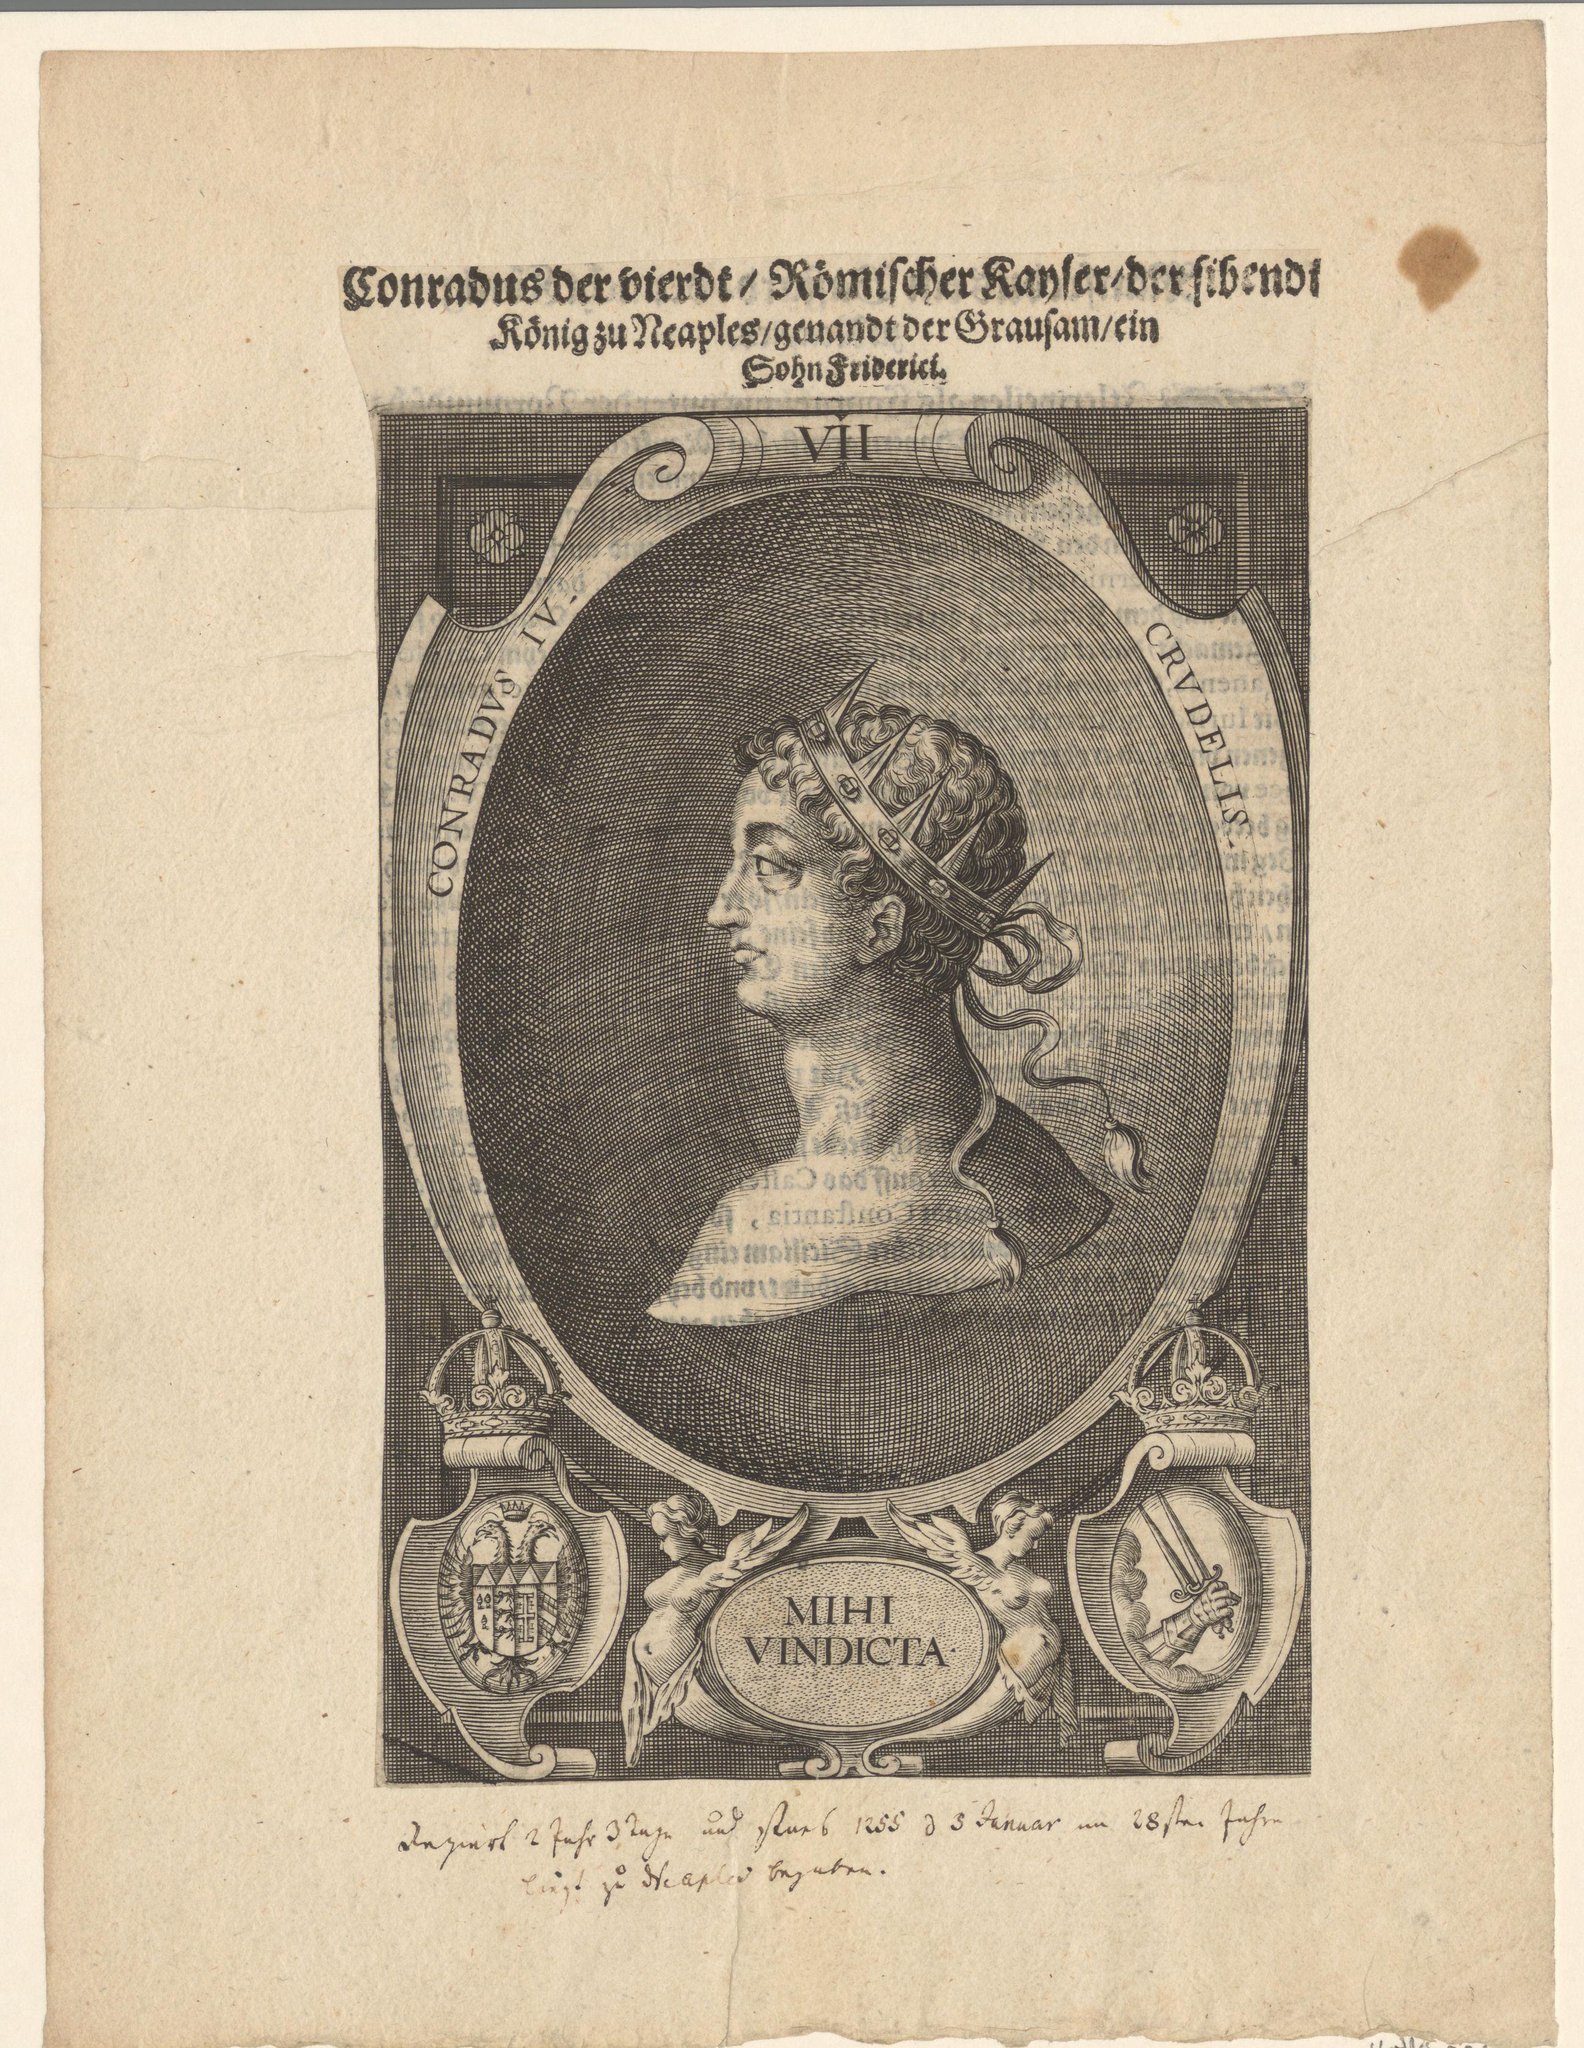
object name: print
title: Portret van koning Koenraad IV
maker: lucas kilian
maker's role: draughtsman, print maker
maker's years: 1579-1637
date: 1589-1624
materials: paper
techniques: engraving, etching, letterpress printing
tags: historical persons, king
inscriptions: collector's mark: Lugt 2228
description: Deze prent is gebruikt in: Mazzella, Scipione, Kilian, Lucas en Custos, Dominicus. Der Neapolitanische Koenige Leben und Bildnisse (...). Augsburg: Lucas Kilian, 1624.